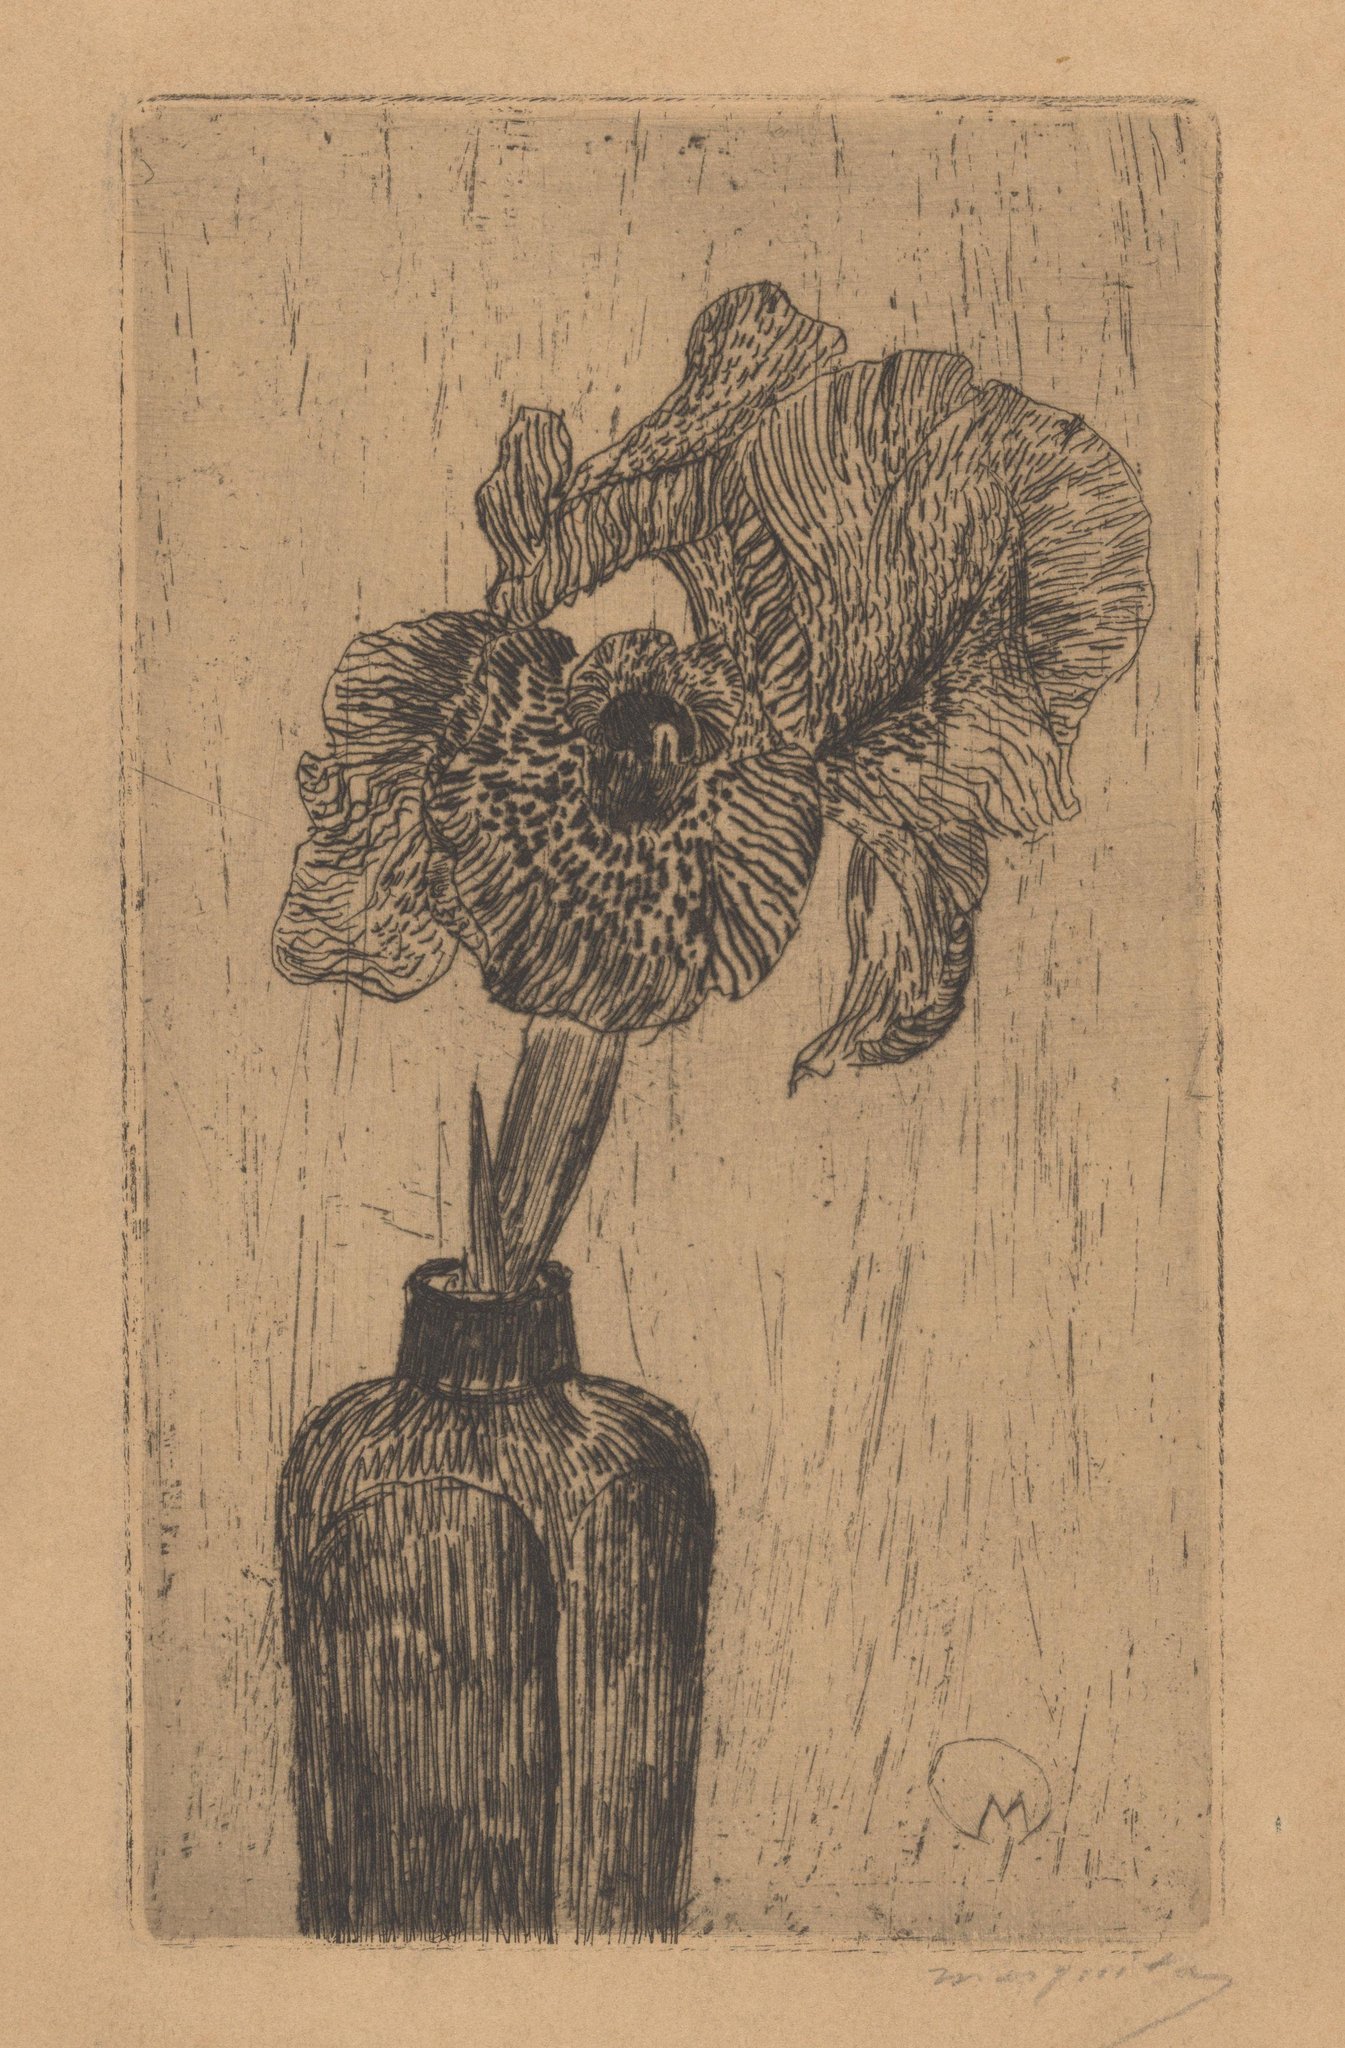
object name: print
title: Iris in vaas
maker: samuel jessurun de mesquita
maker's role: draughtsman, print maker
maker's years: 1868-1944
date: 1893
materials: paper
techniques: etching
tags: flowers in a vase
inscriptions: collector's mark: Lugt 2228